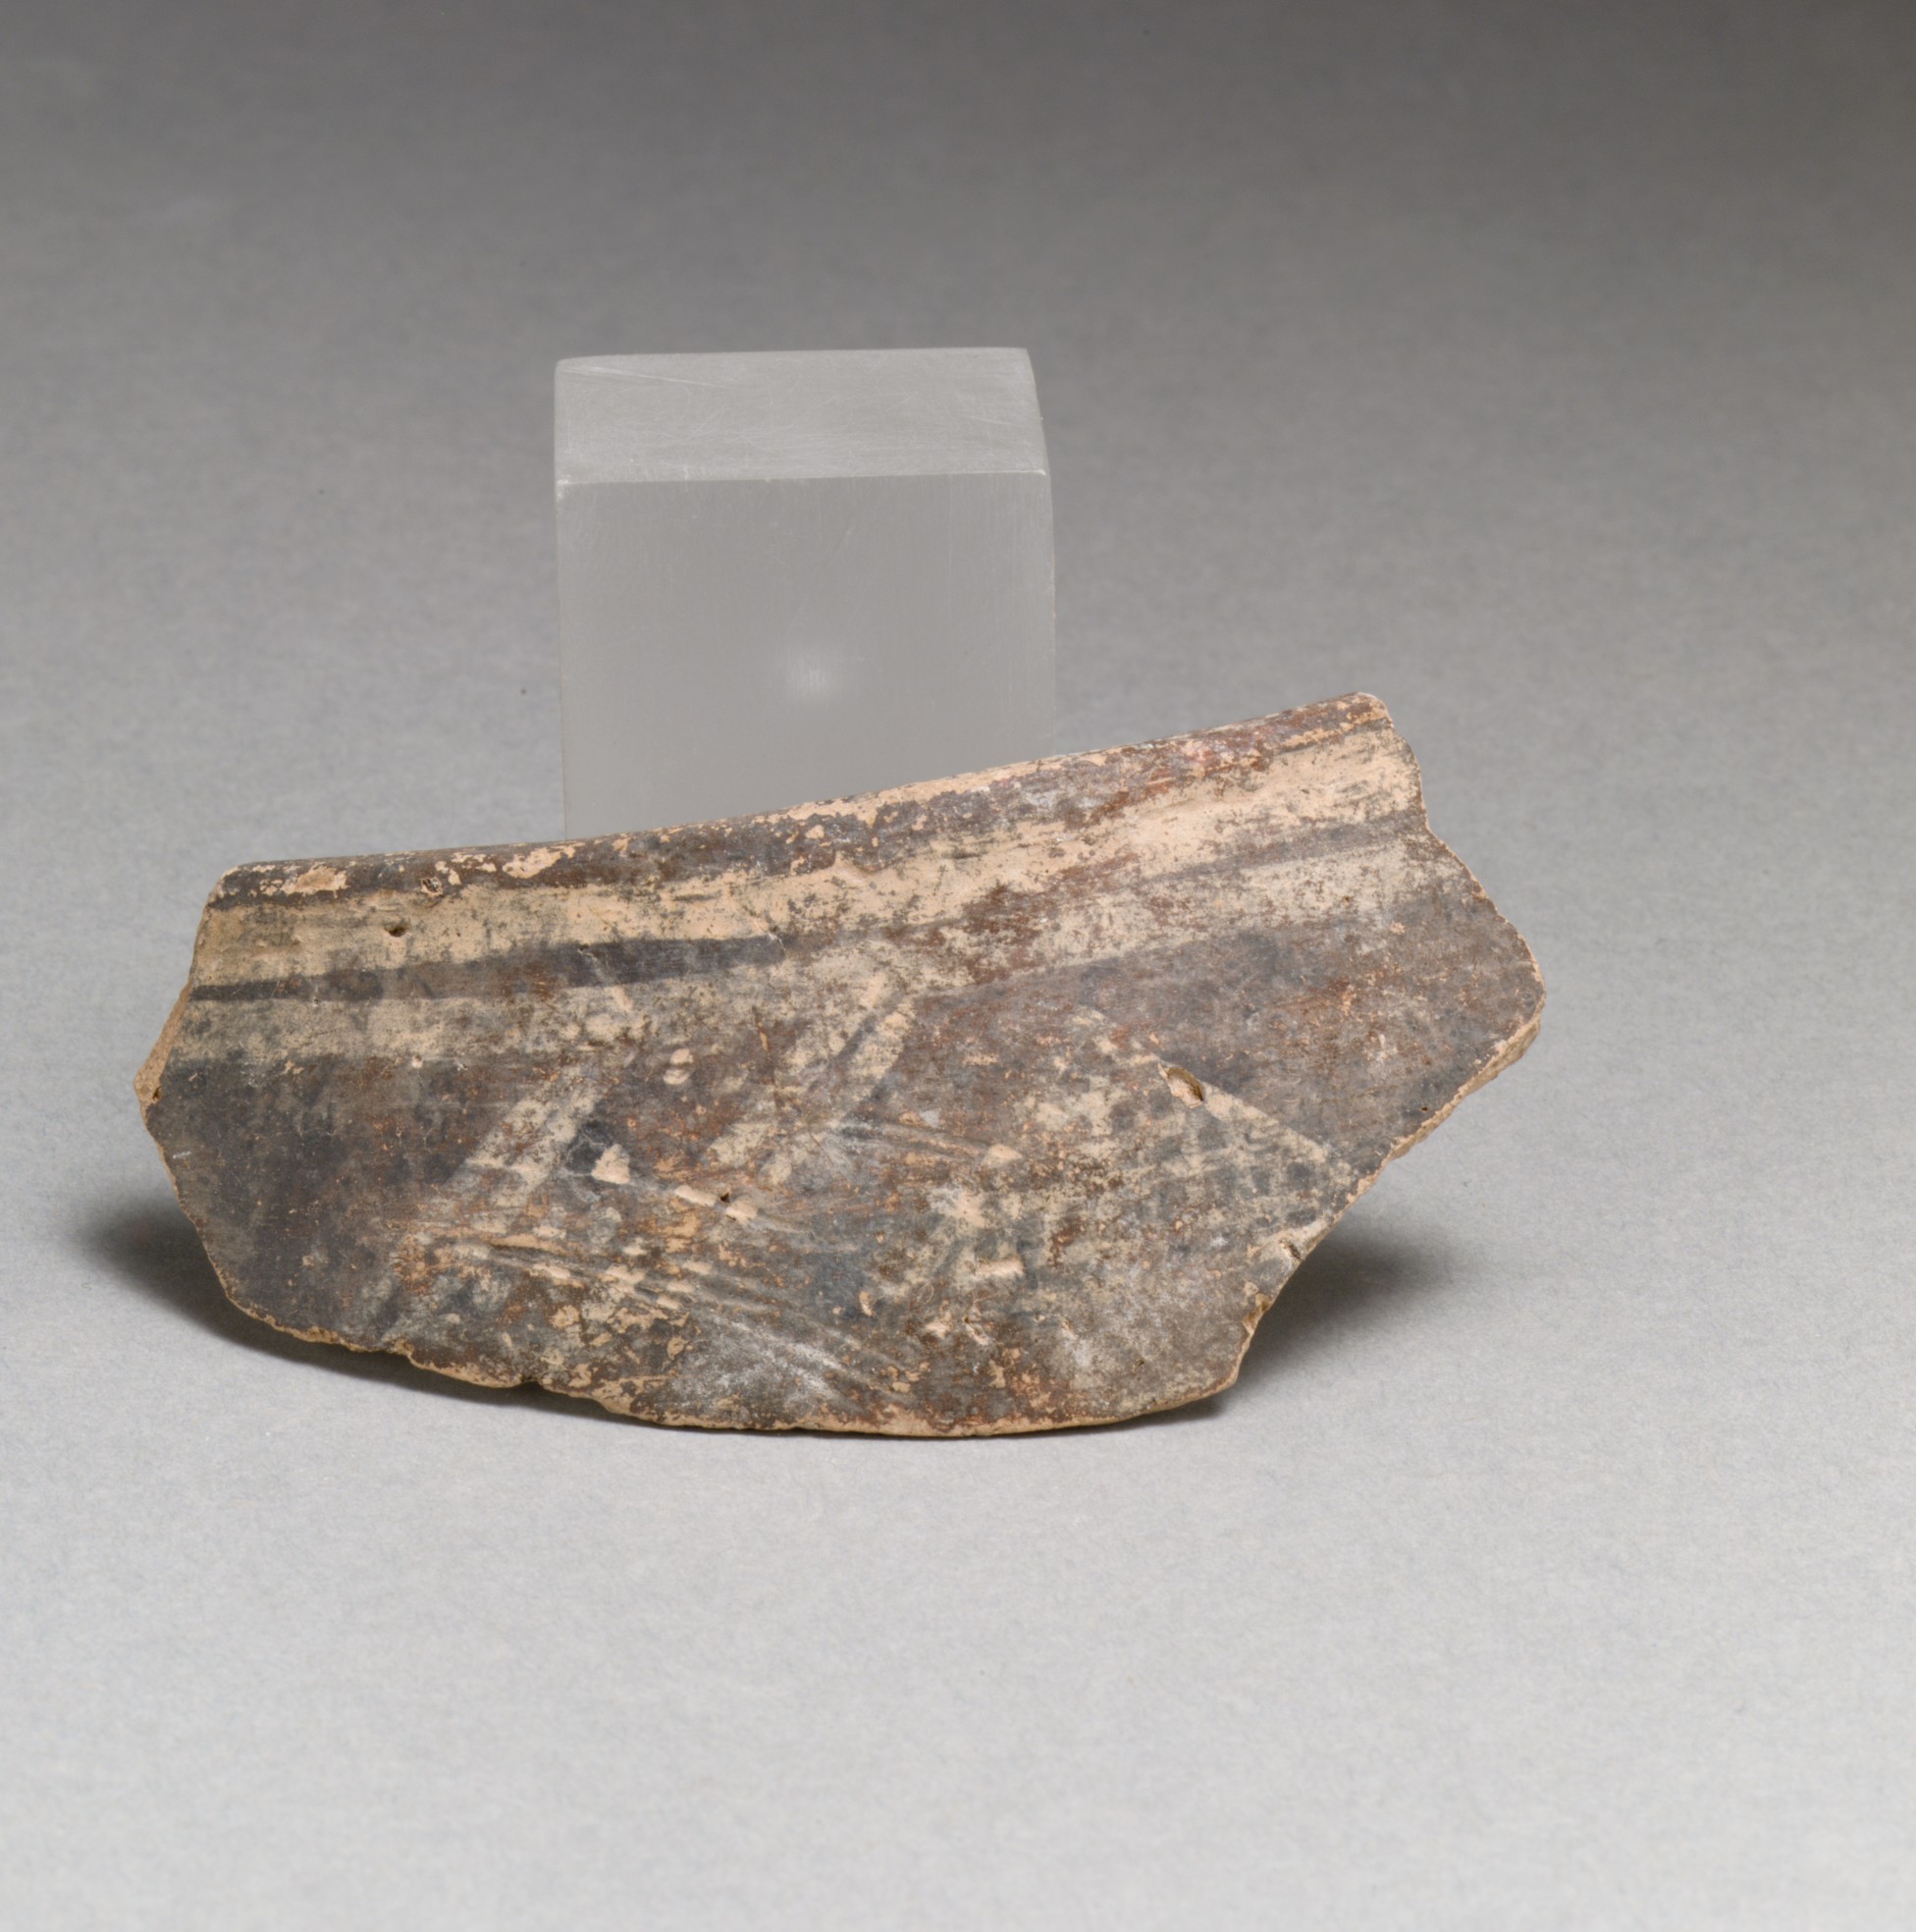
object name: vase fragment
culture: minoan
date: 2600-2000 BCE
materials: terracotta